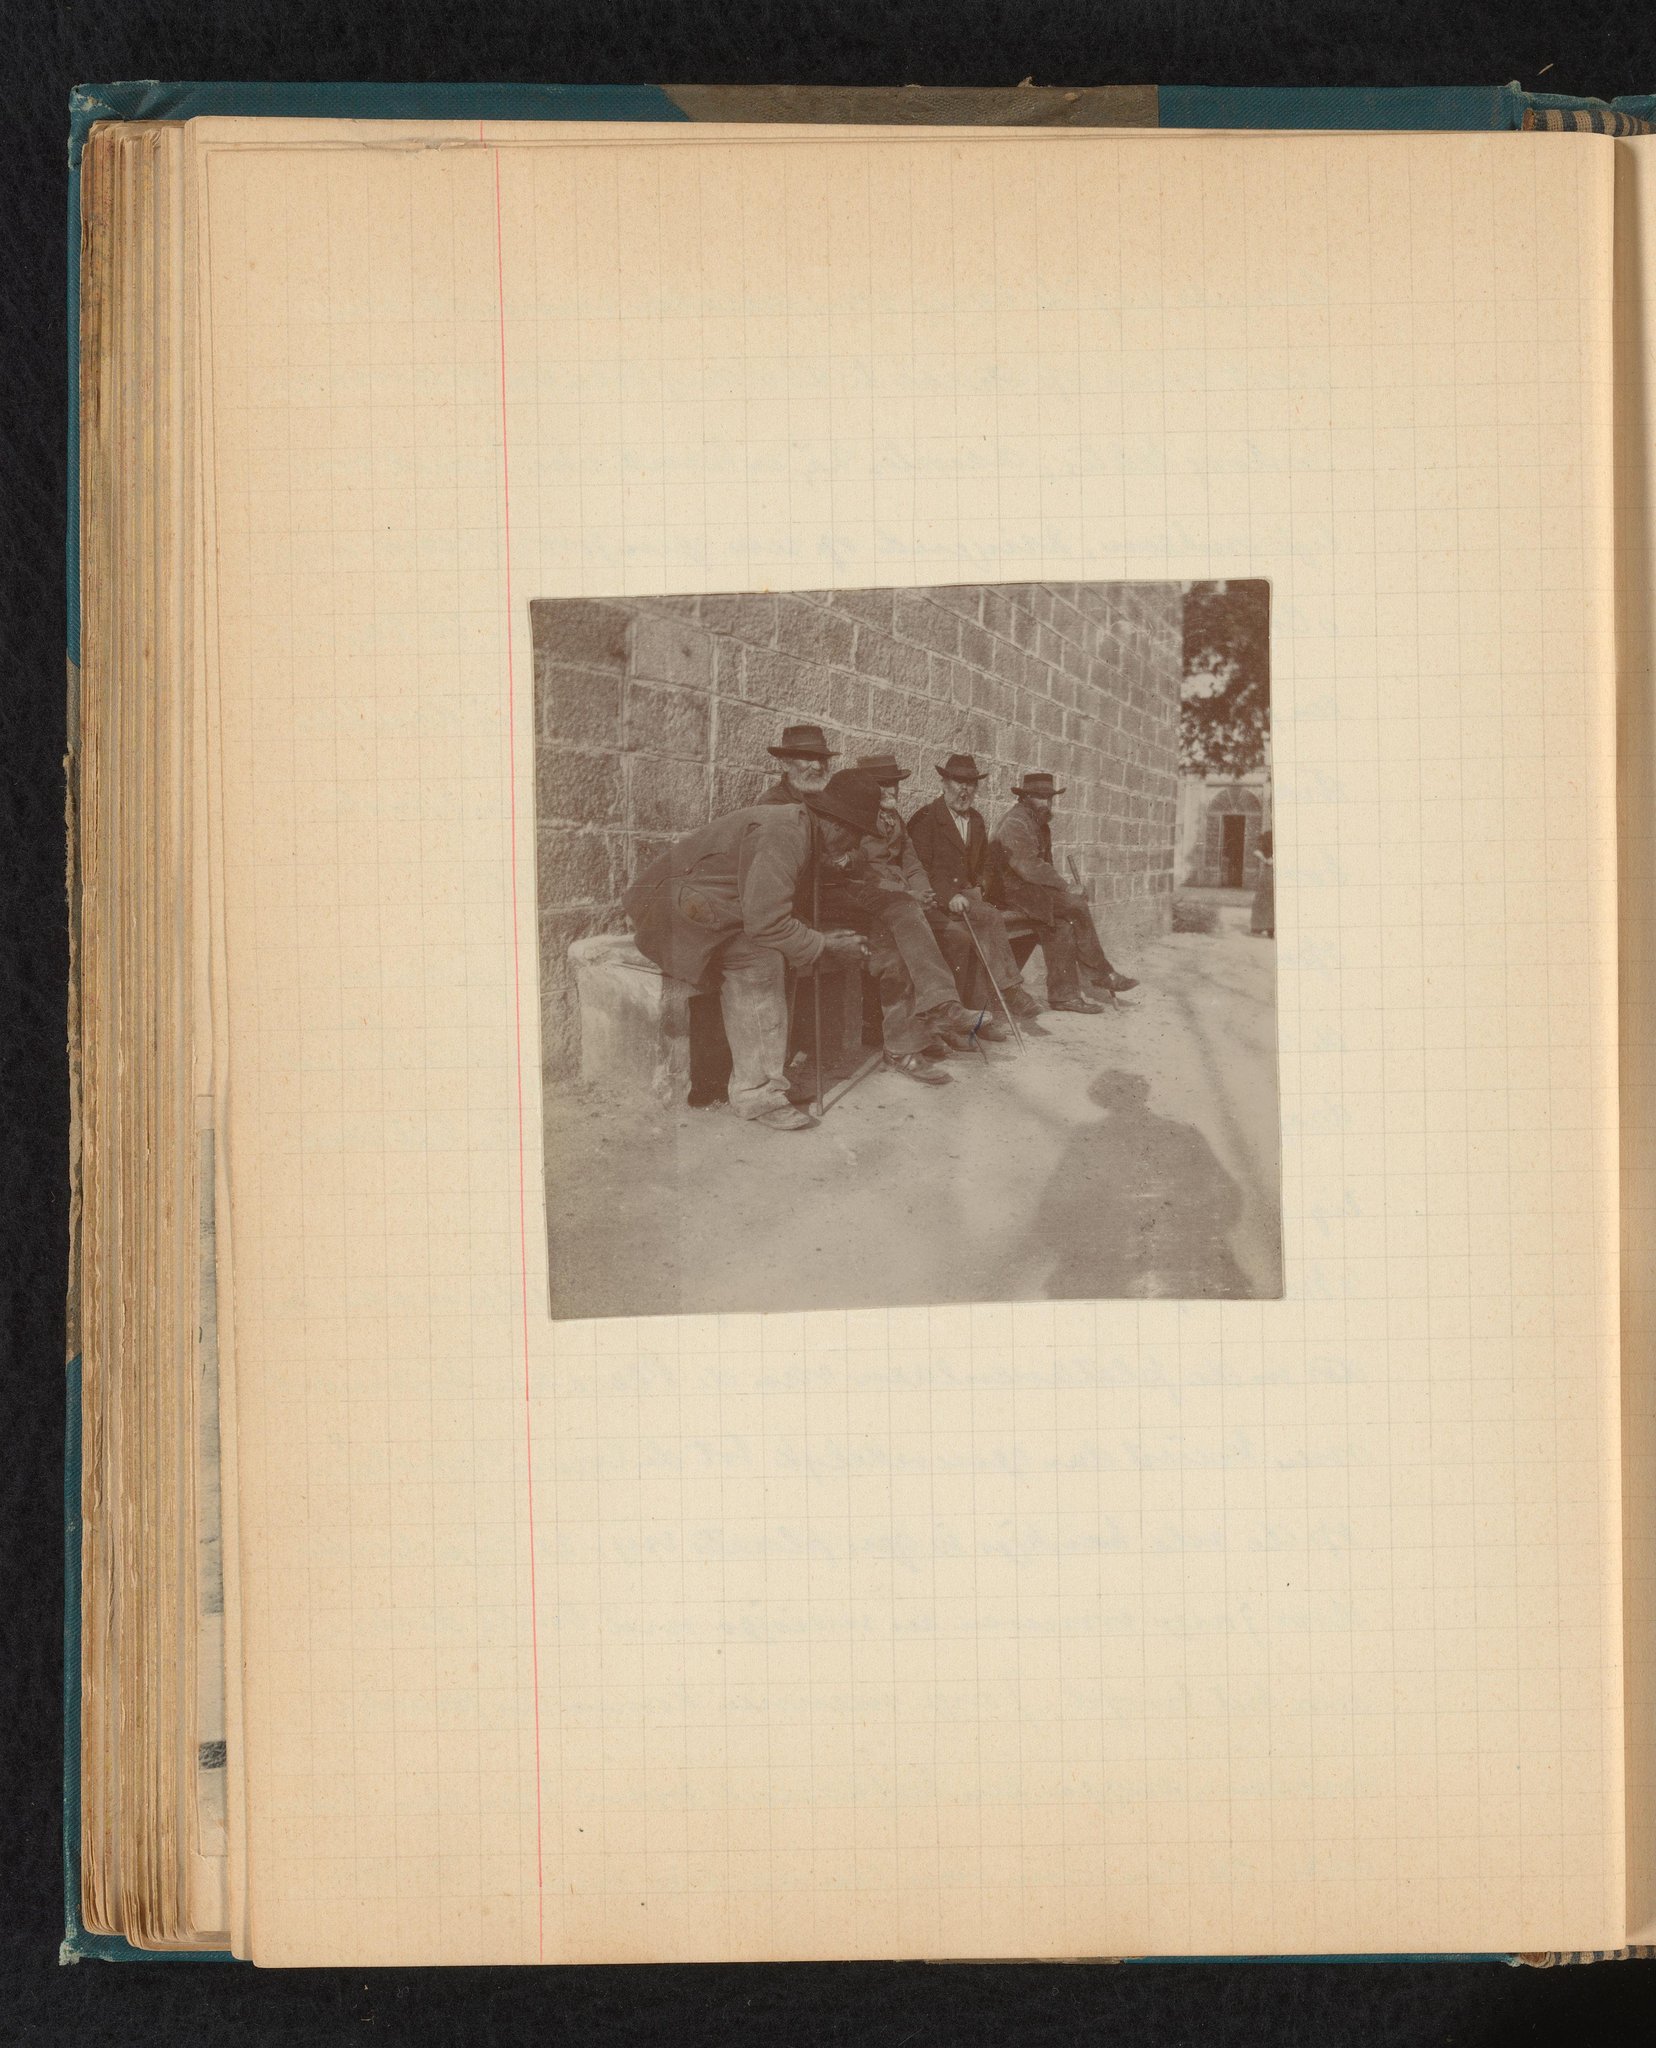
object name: photograph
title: Groep oudere mannen met hoeden zitten op een bank voor een stenen muur in Ajaccio, Corsica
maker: théodore van lelyveld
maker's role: painter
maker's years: 1867-1954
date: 1902-1904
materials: paper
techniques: daylight paper print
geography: ajaccio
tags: sitting figure, head-gear, anonymous historical person portrayed alone, old man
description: Deze foto's maken deel uit van een album.